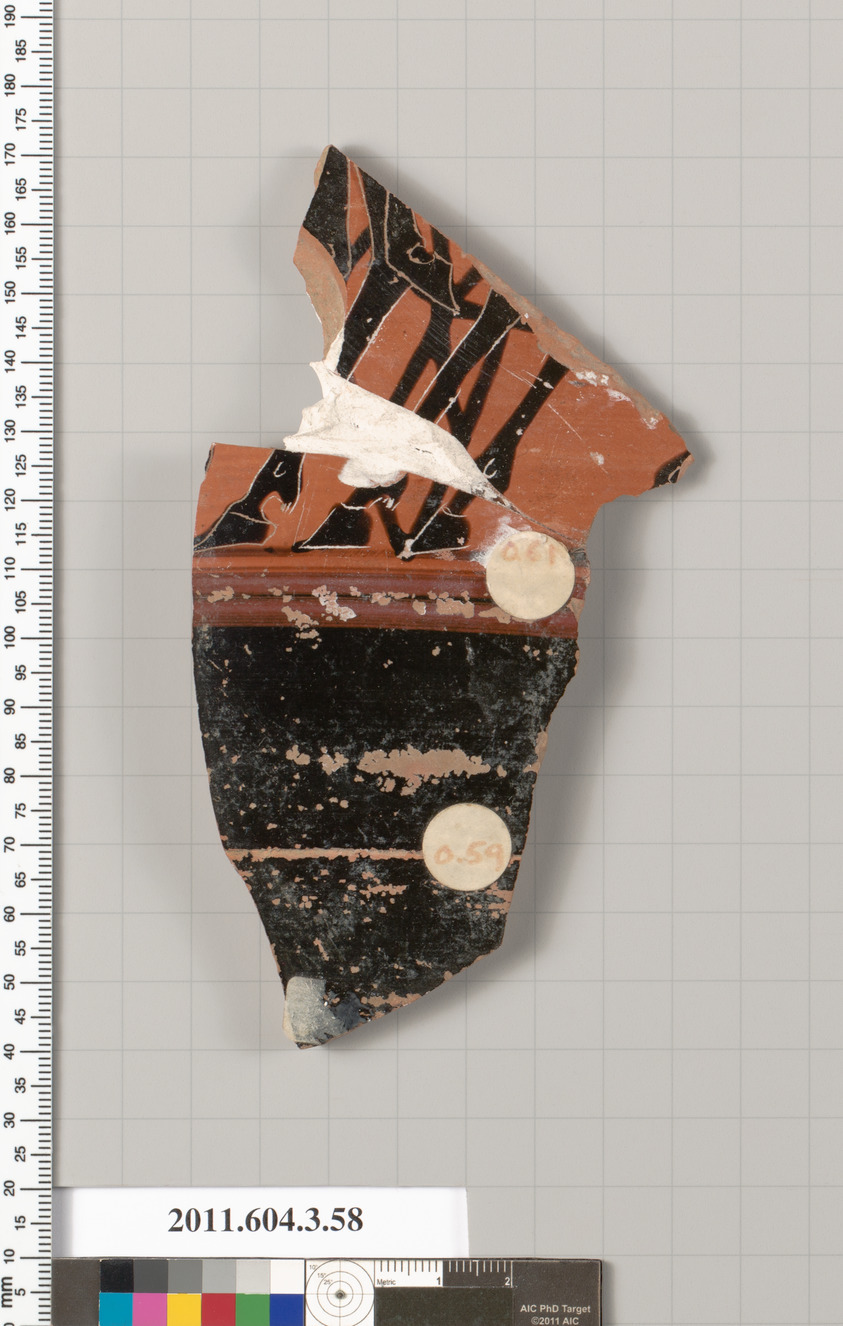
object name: amphora fragment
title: Terracotta fragment of an amphora (jar)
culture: greek, attic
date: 525-501 BCE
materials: terracotta